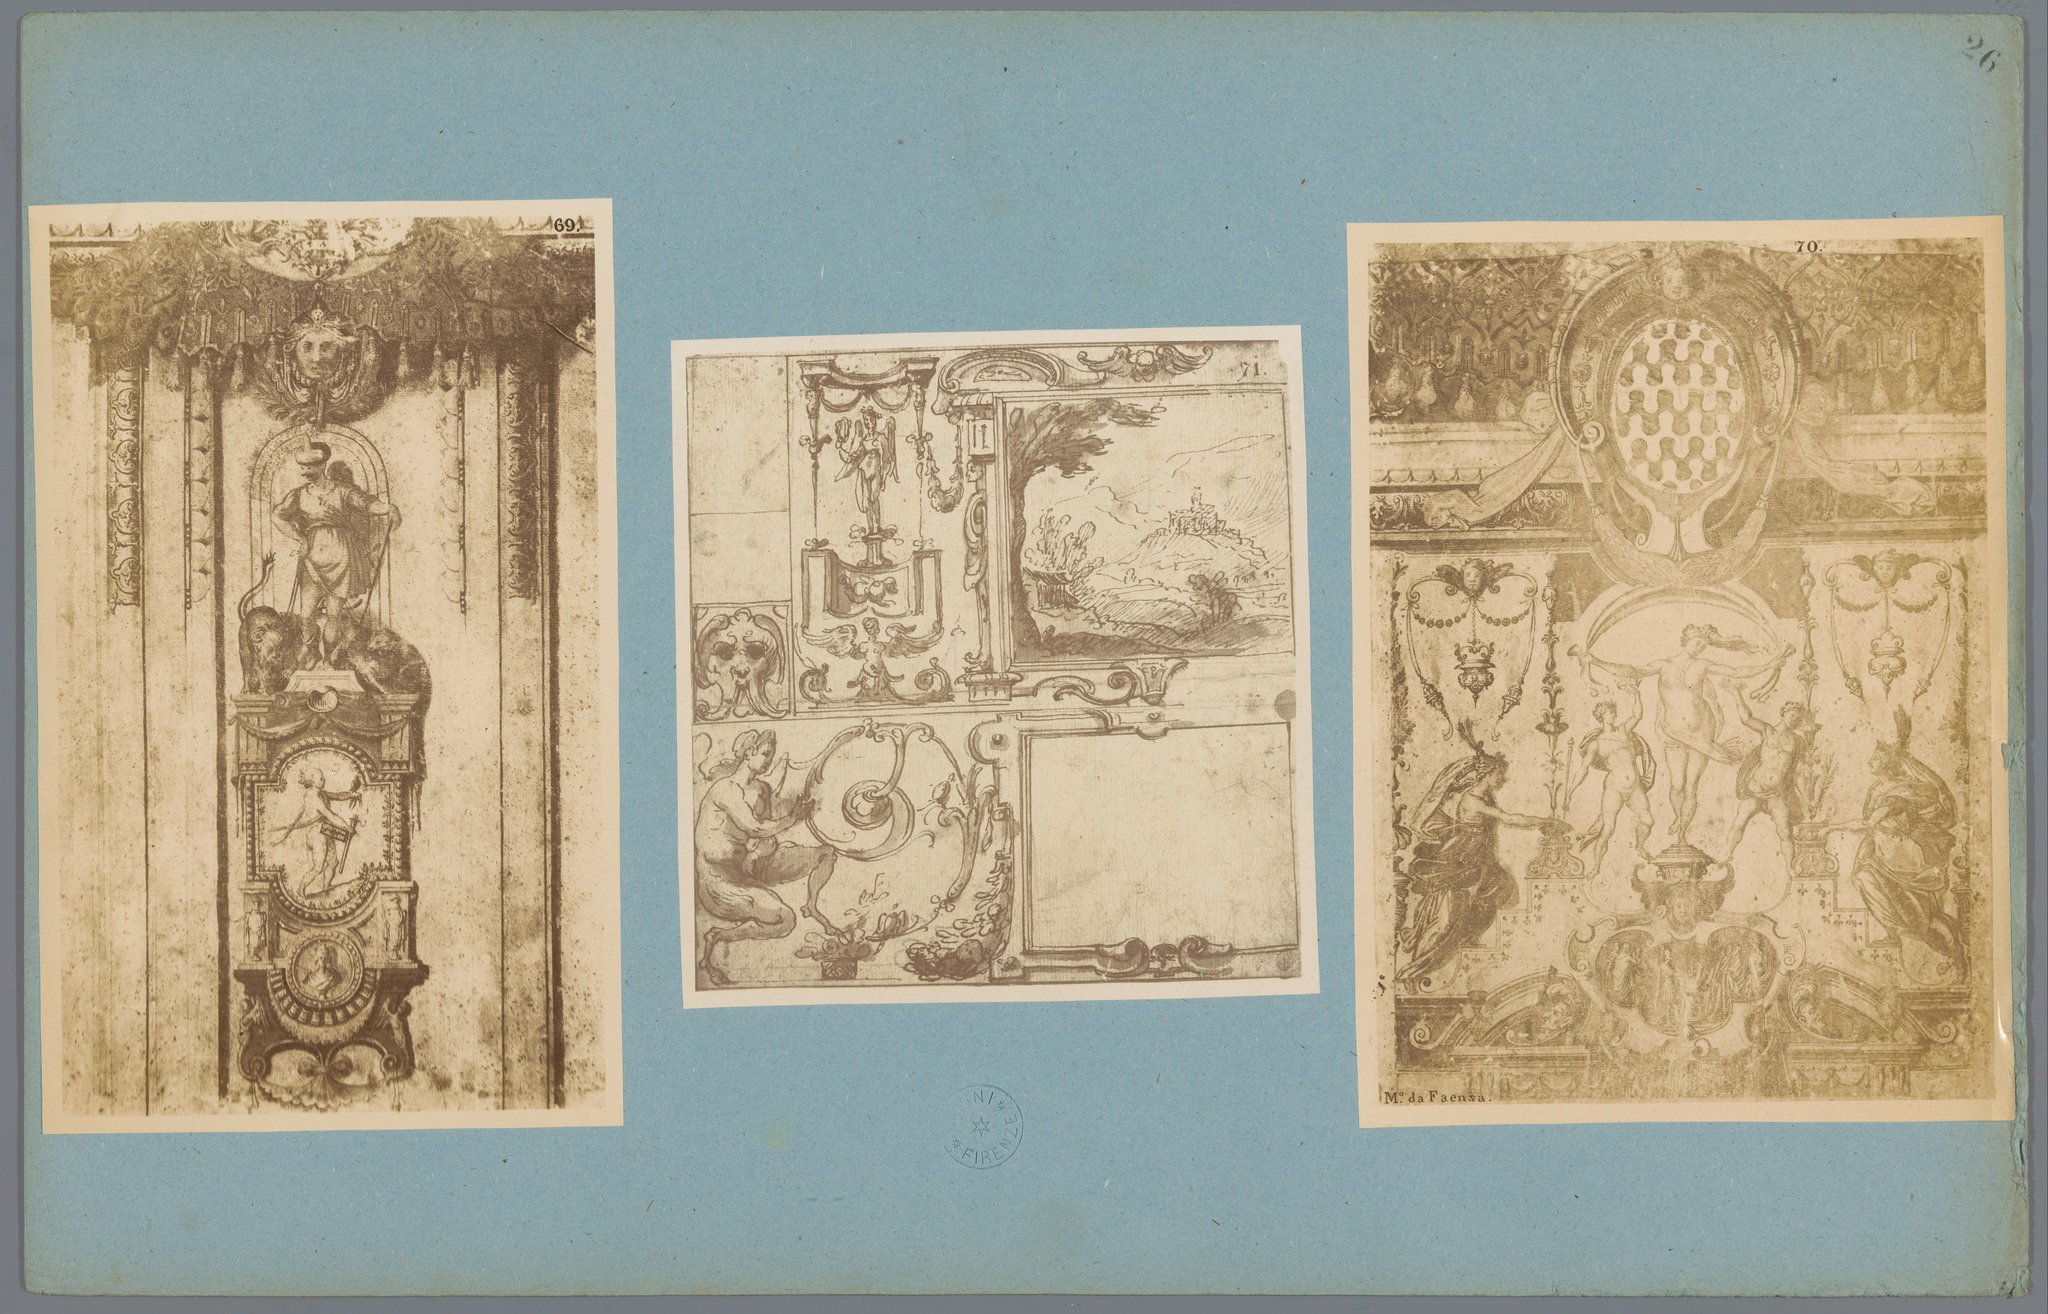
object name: photograph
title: Drie fotoreproducties van vermoedelijk tekeningen van wanddecoraties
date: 1875-1900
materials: cardboard, photographic support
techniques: albumen print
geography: europe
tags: coat of arms (as symbol of the state, etc.), drawing, sketch, landscapes, fortuna as roman personification, piece of sculpture, reproduction of a piece of sculpture, europe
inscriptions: collector's mark: Lugt 3937, number: ‘71.’, number: ‘70.’, name: ‘C. Pini Firenze’, number: ‘26’, name: ‘M. da Faenza.’, number: ‘69.’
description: Links (69) vermoedelijk een sculptuur van een man met een muts en een leeuw, midden (71) een wanddecoratie met een landschap, rechts (70) een wanddecoratie met vermoedelijk Fortuna onder een wapenschild door Marco Marchetti.